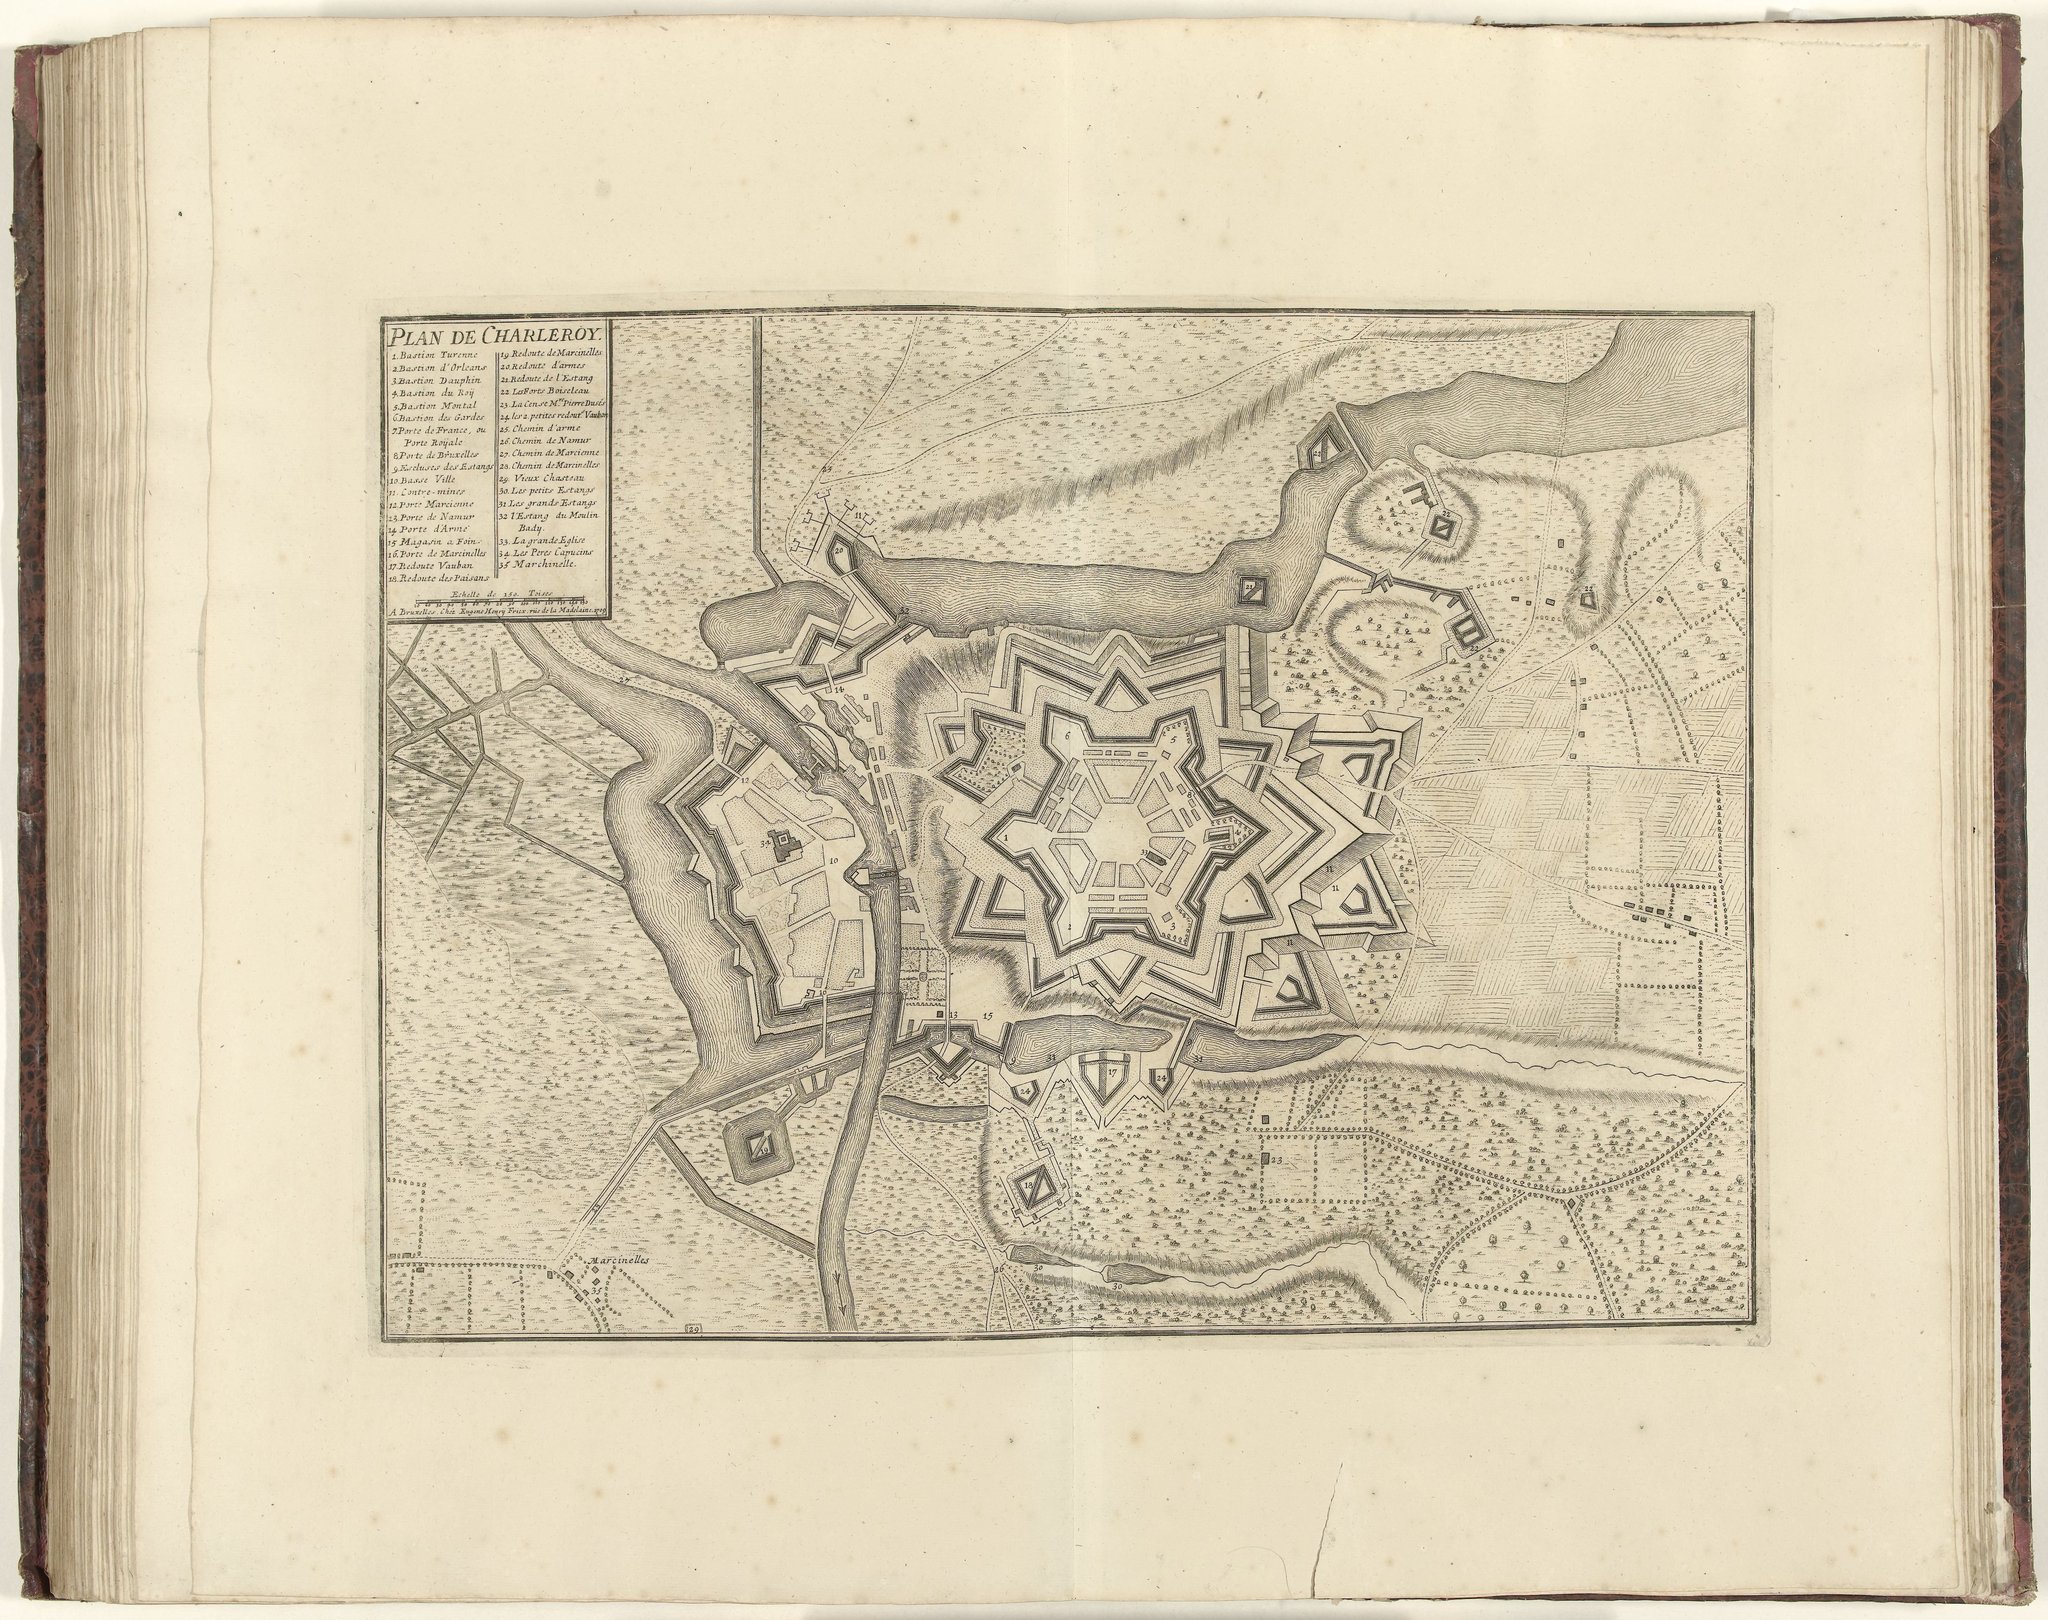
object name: map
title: Plan de Charleroi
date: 1709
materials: paper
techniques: etching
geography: brussels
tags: maps of cities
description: Plattegrond van Charleroi, 1709. Linksboven de legenda 1-35. Onderdeel van een gebundelde verzameling van plannen van veldslagen en steden vermaard in de Spaanse Successieoorlog.